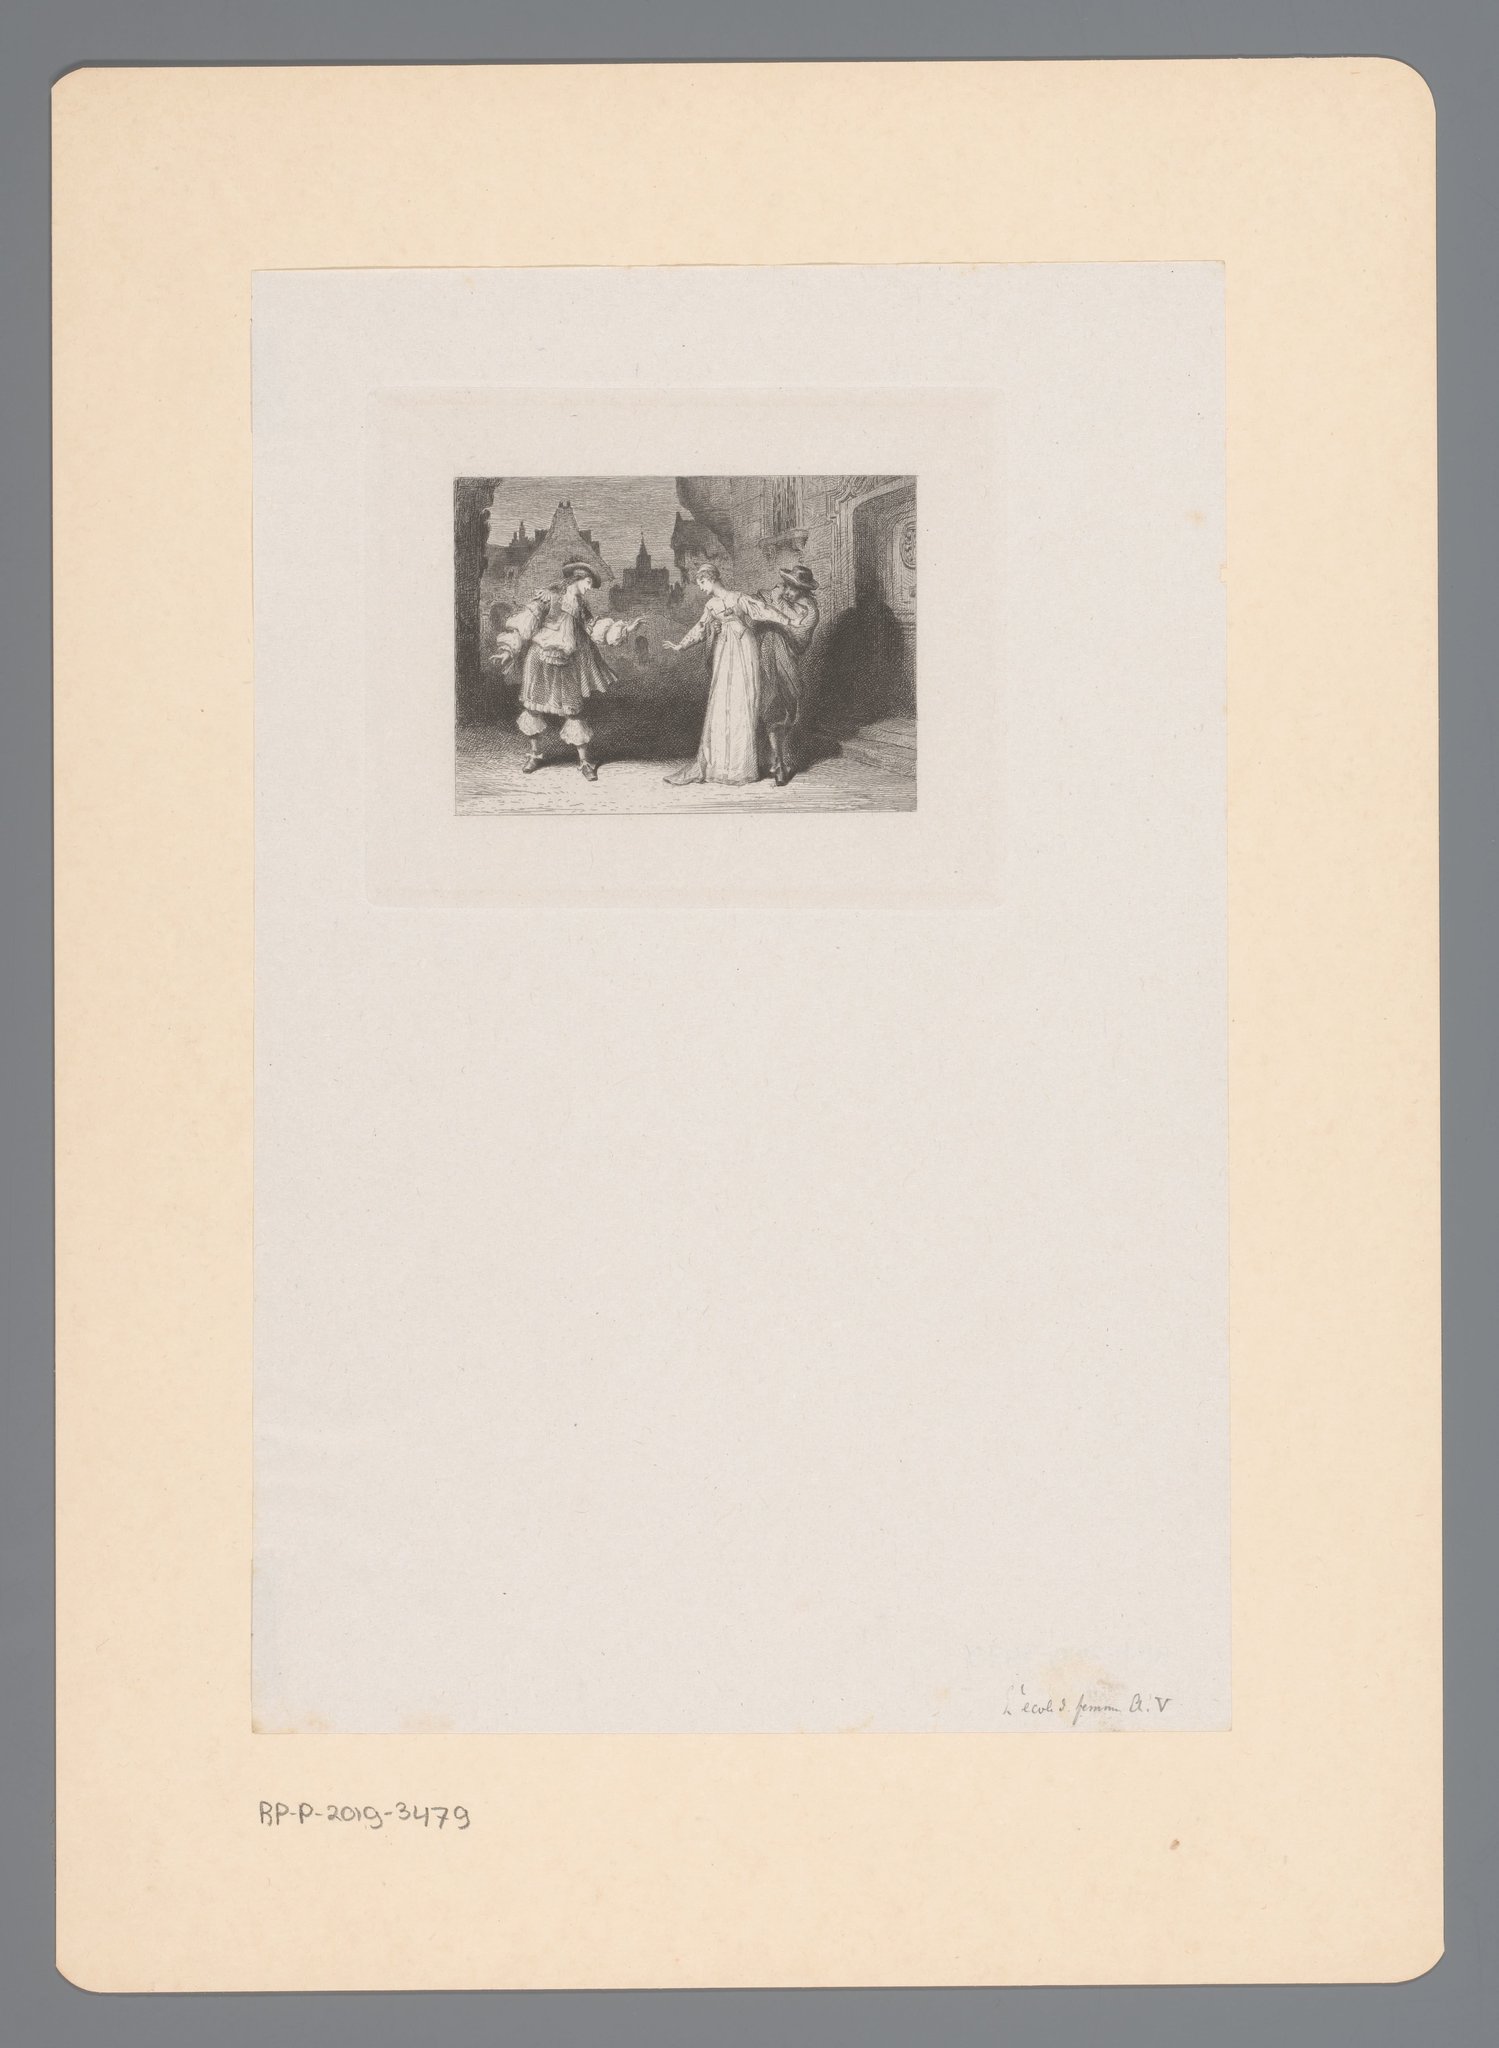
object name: print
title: Molière Théatre Choisi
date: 1878-1879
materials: paper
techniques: drypoint, etching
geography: tours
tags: theatre, theatrical performance, the envious friends; criticizing bystanders ~ love couple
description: Akte V, scène III uit "L'École des Femmes" van Molière. Arnolphe haalt Agnès weg bij Horace om een einde aan hun liefdesverklaringen te maken.